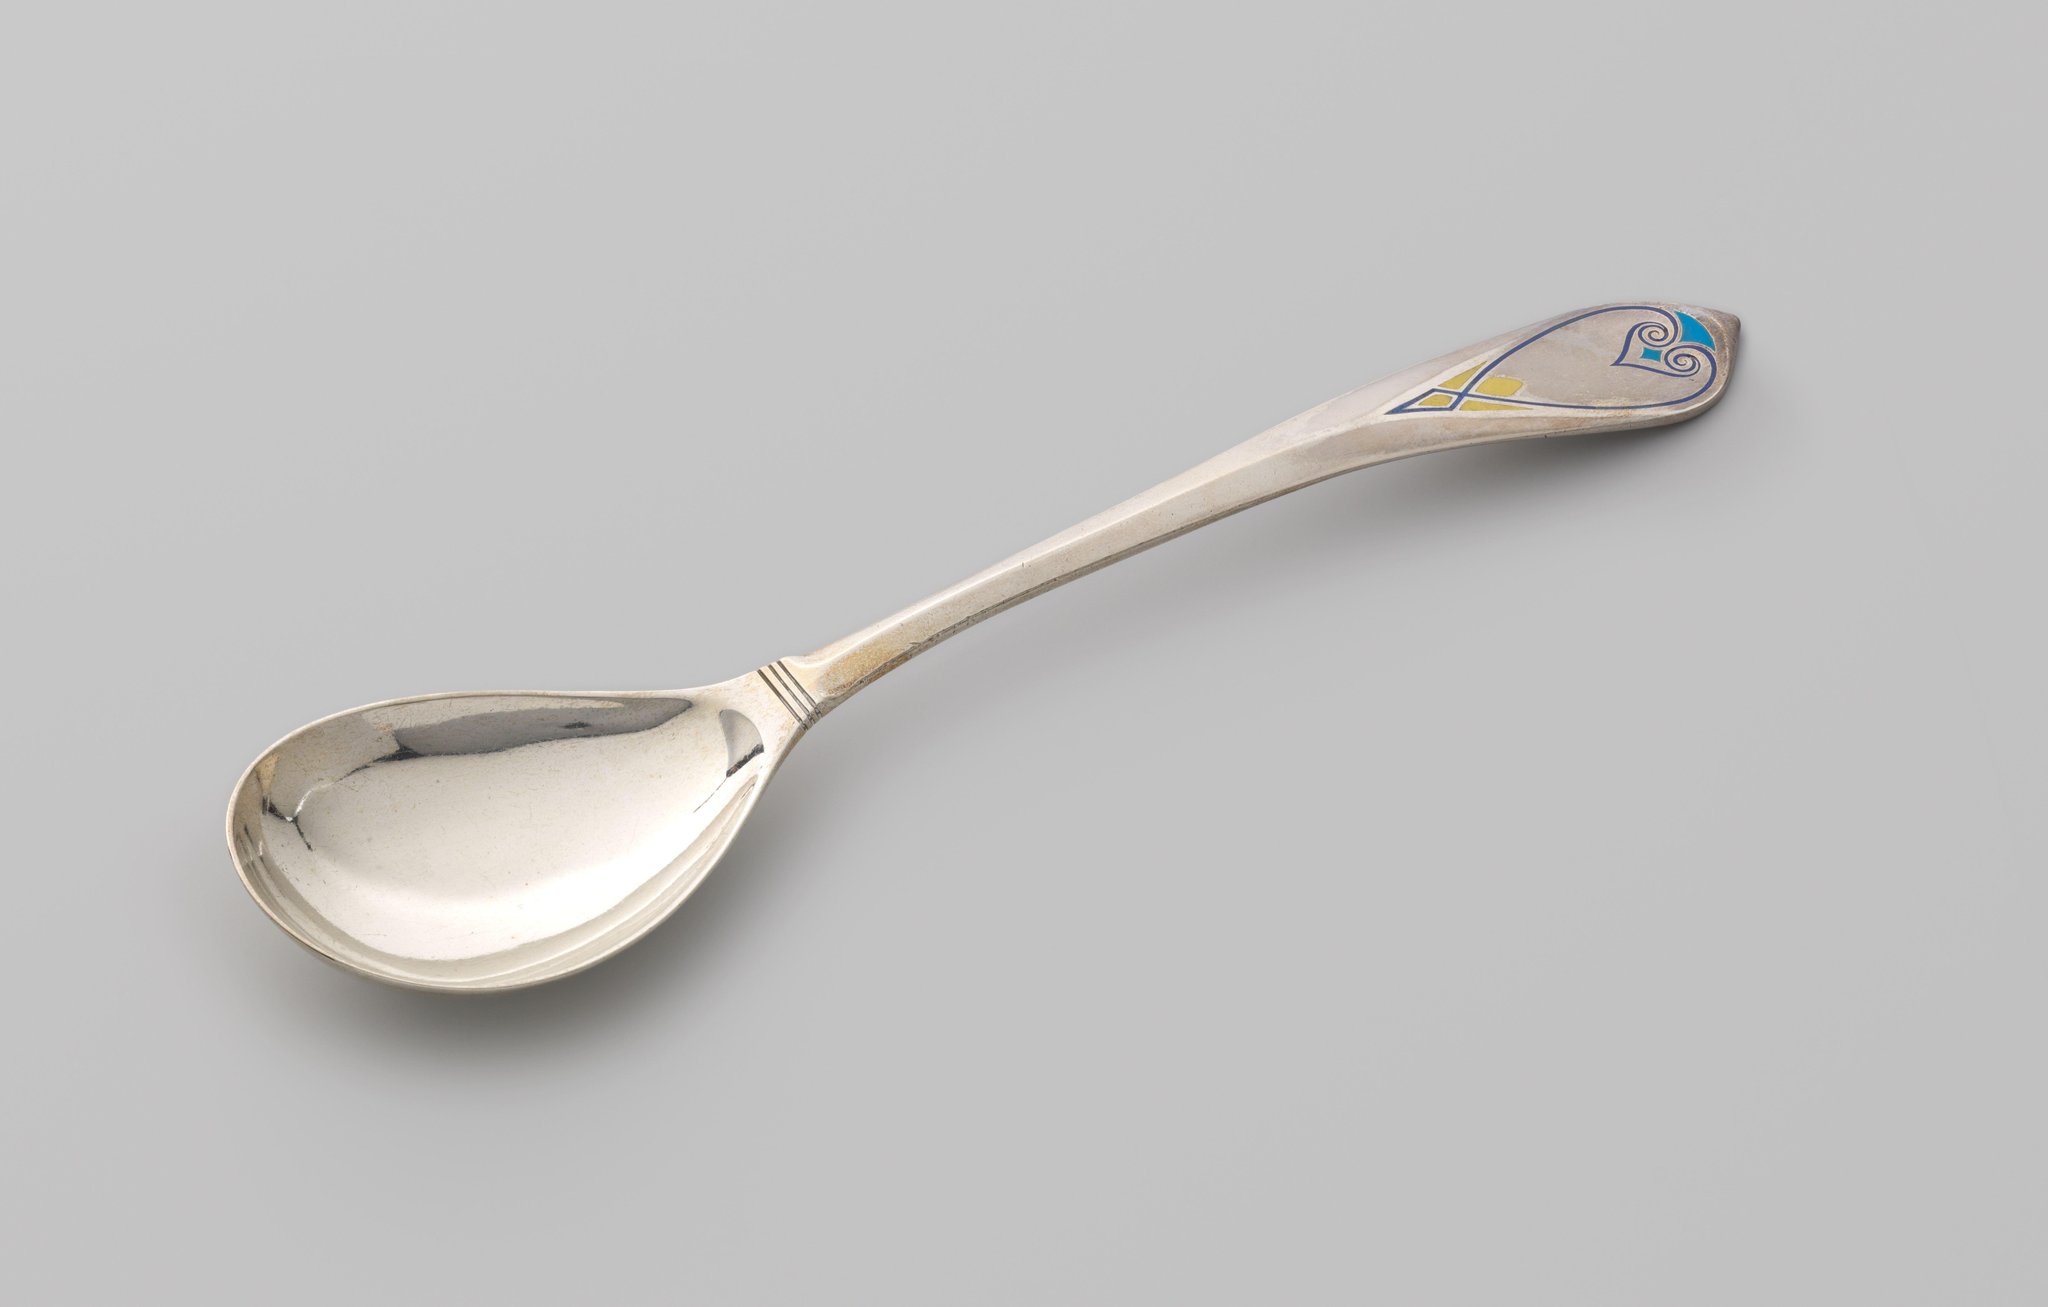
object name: compôte opscheplepel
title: Compôte-opscheplepel met peervormige bak en steel met een symmetrisch patroon in email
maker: johannes blinxma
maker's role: silversmith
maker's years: 1872-1942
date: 1931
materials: silver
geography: amsterdam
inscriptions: hallmark, maker's mark, date letter: ‘W’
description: De peervormige bak gaat geleidelijk over in de platte, gebogen steel, die zich verbreedt naar het spits ovale, opkrullende uiteinde. Bij de aanzet van bak naar steel wordt de lepel aan bovenzijde en zijkanten geleed door een dubbel profiel. Over het midden van de steel loopt een ribbel, die zich bij het uiteinde splitst om een druppelvormig veld te omsluiten. Dit veld is versierd met een symmetrisch patroon van lijnen en vlakken in twee kleuren blauw en geel émail champlevé.